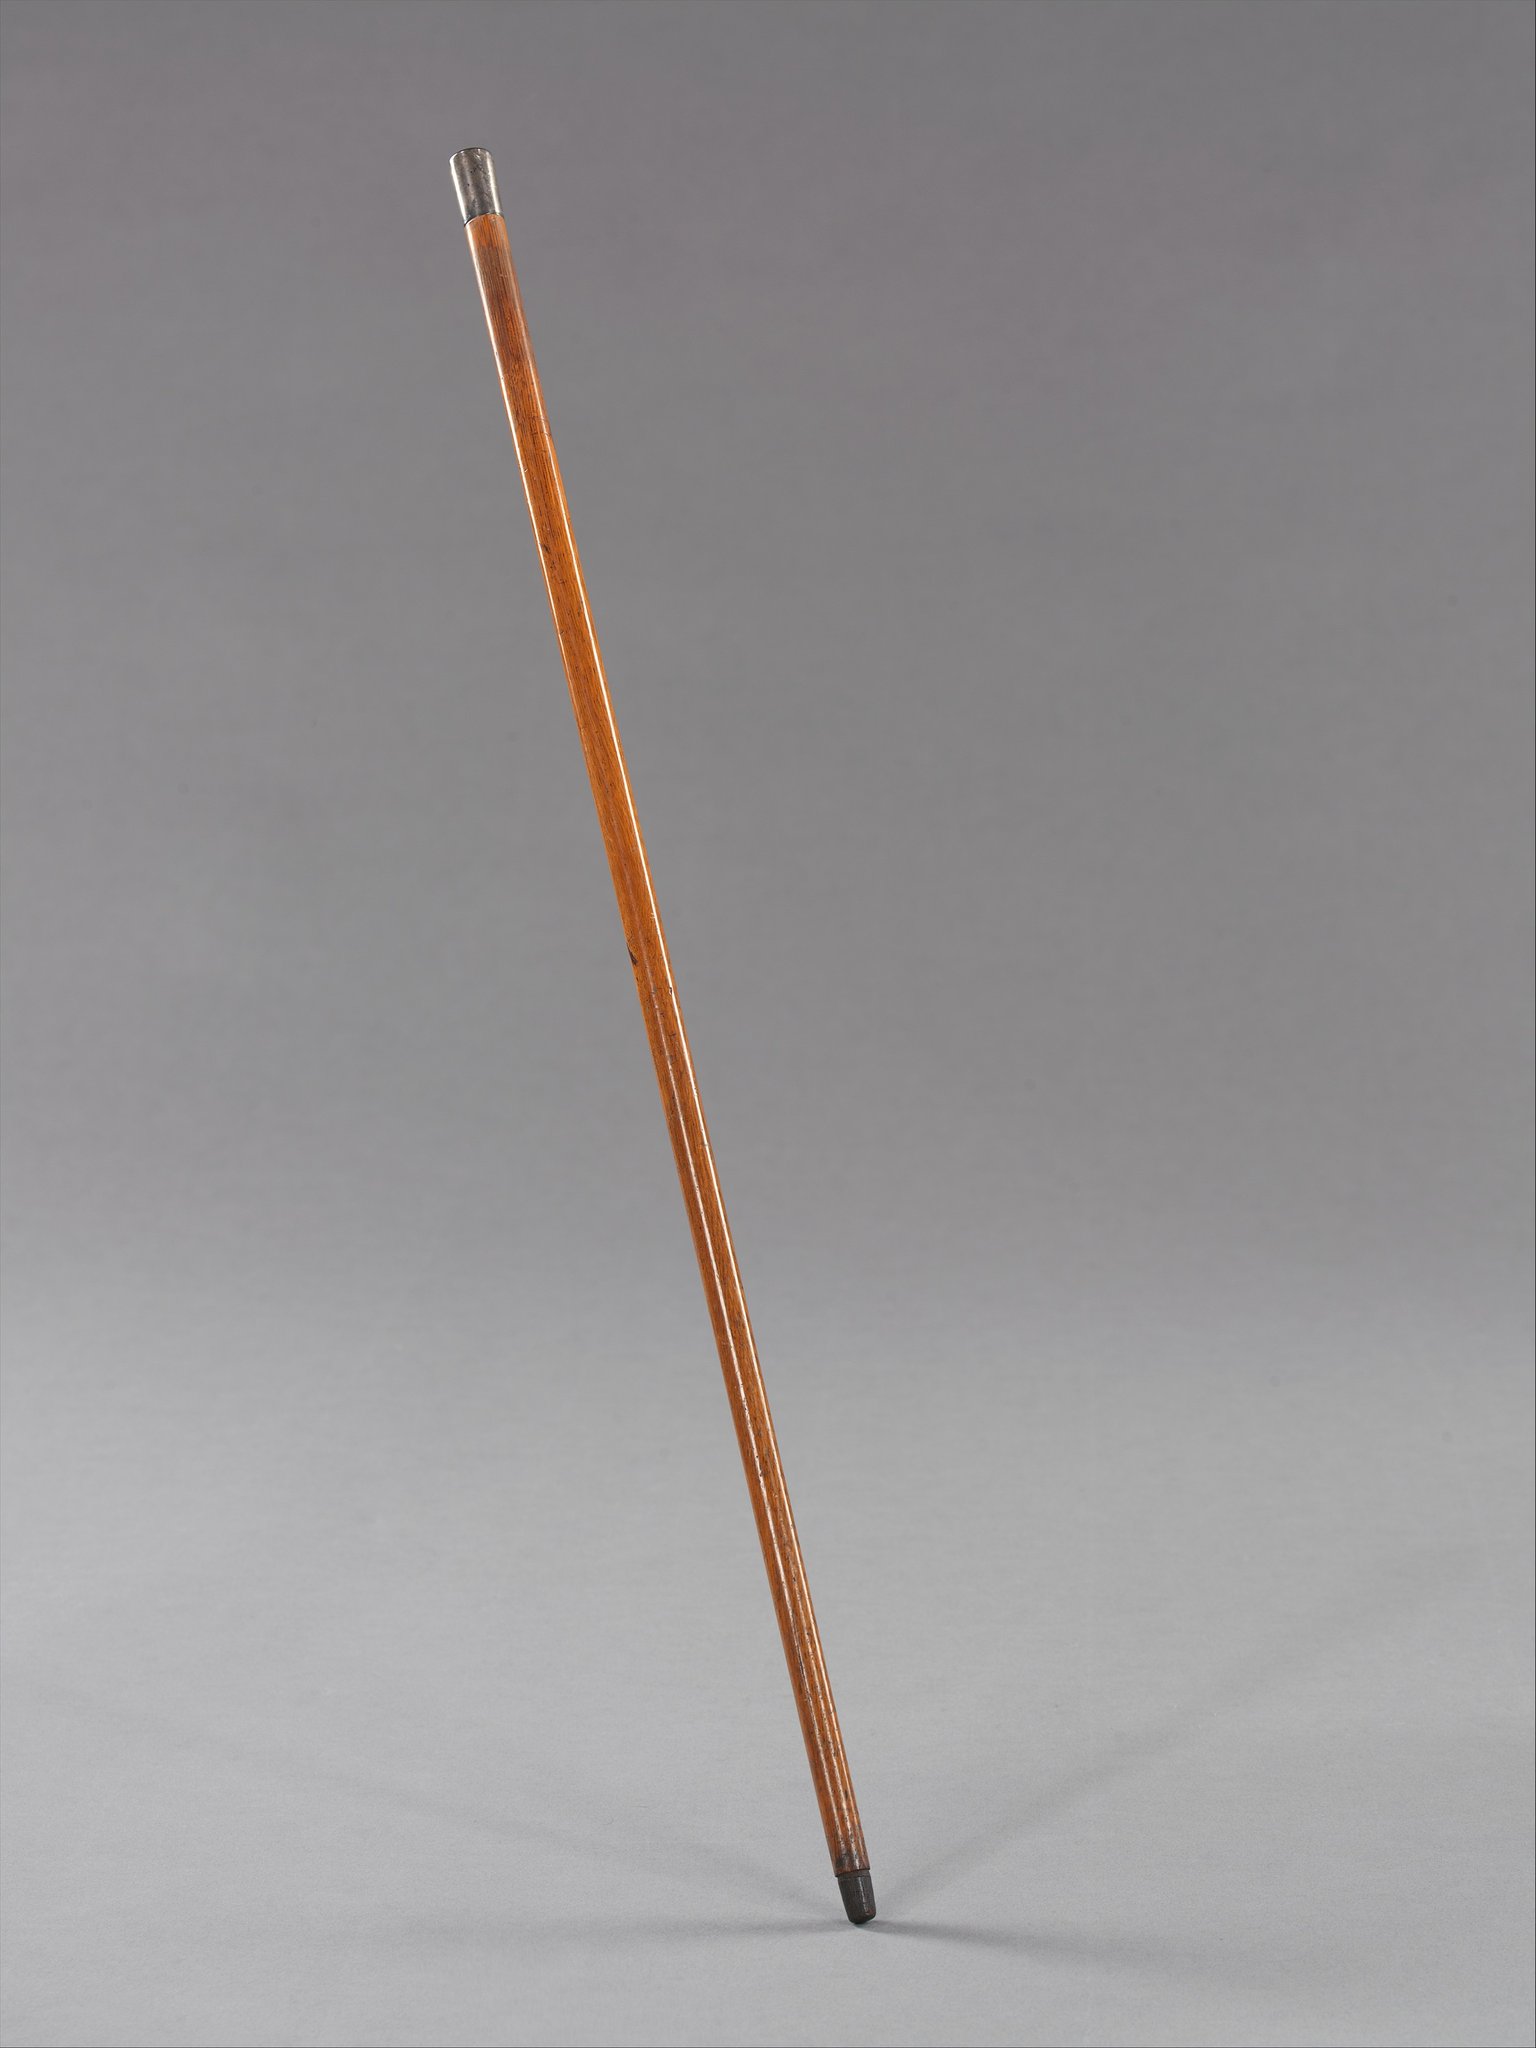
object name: cane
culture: american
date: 1883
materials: metal, wood